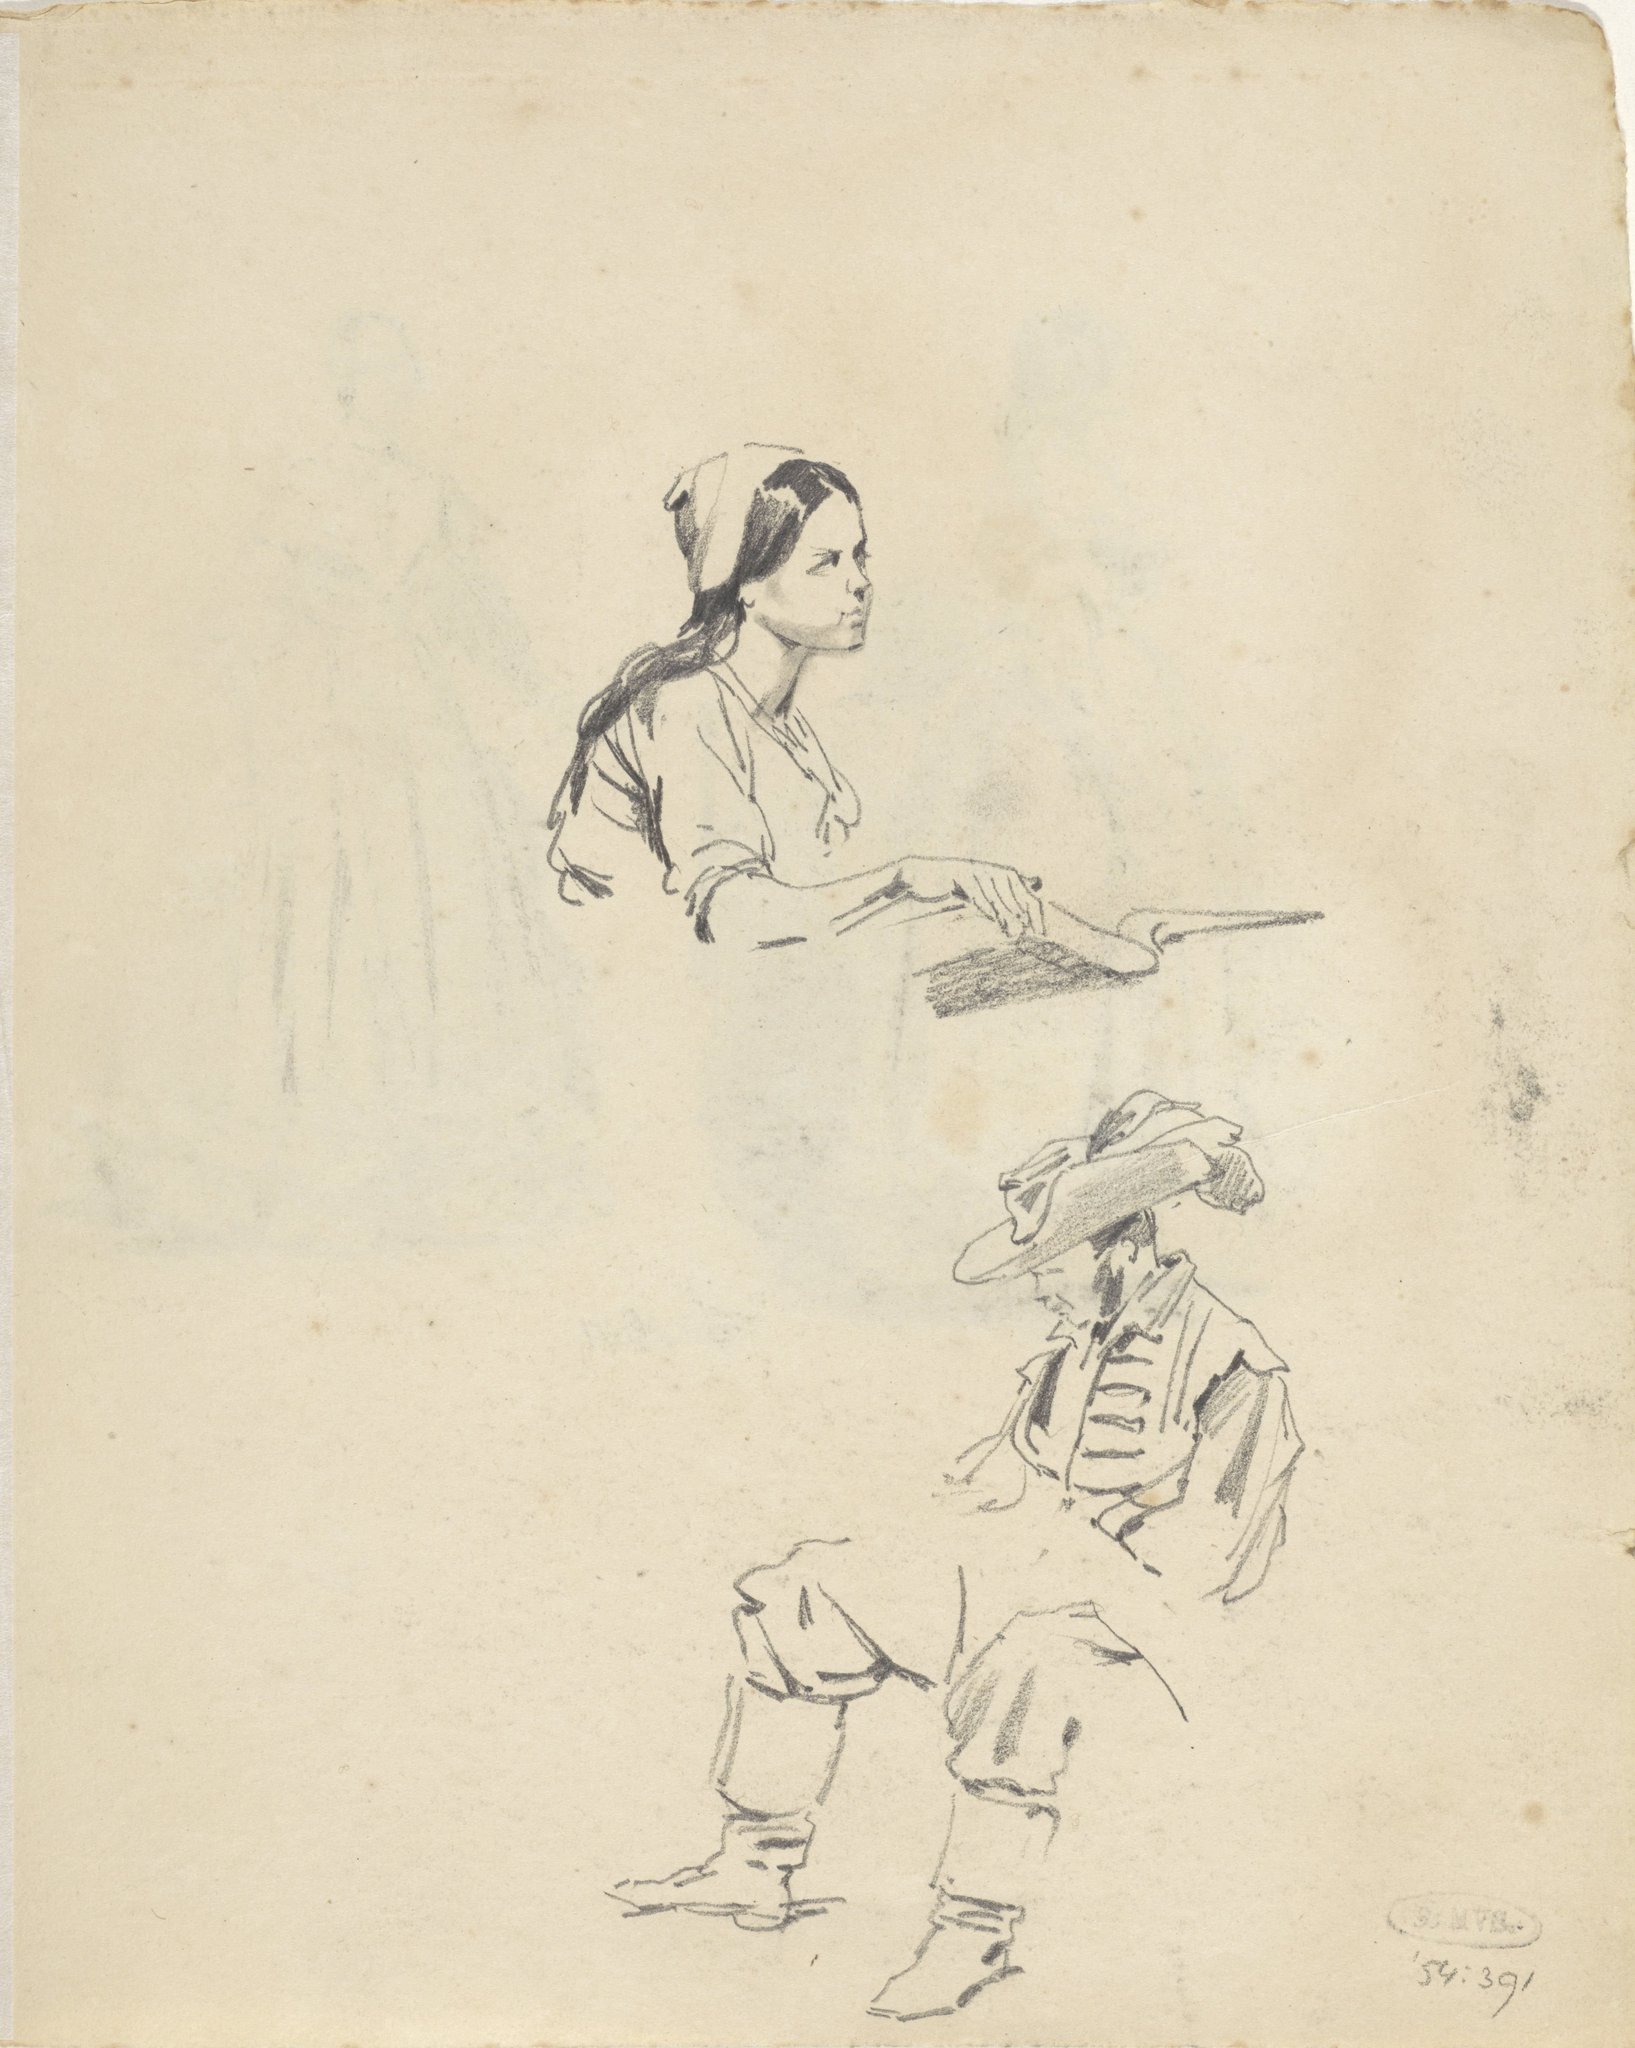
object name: drawing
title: Studies van een vrouw met boek en een zittende soldaat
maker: pieter van loon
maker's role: draughtsman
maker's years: 1801-1873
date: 1841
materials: paper, pencil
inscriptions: date